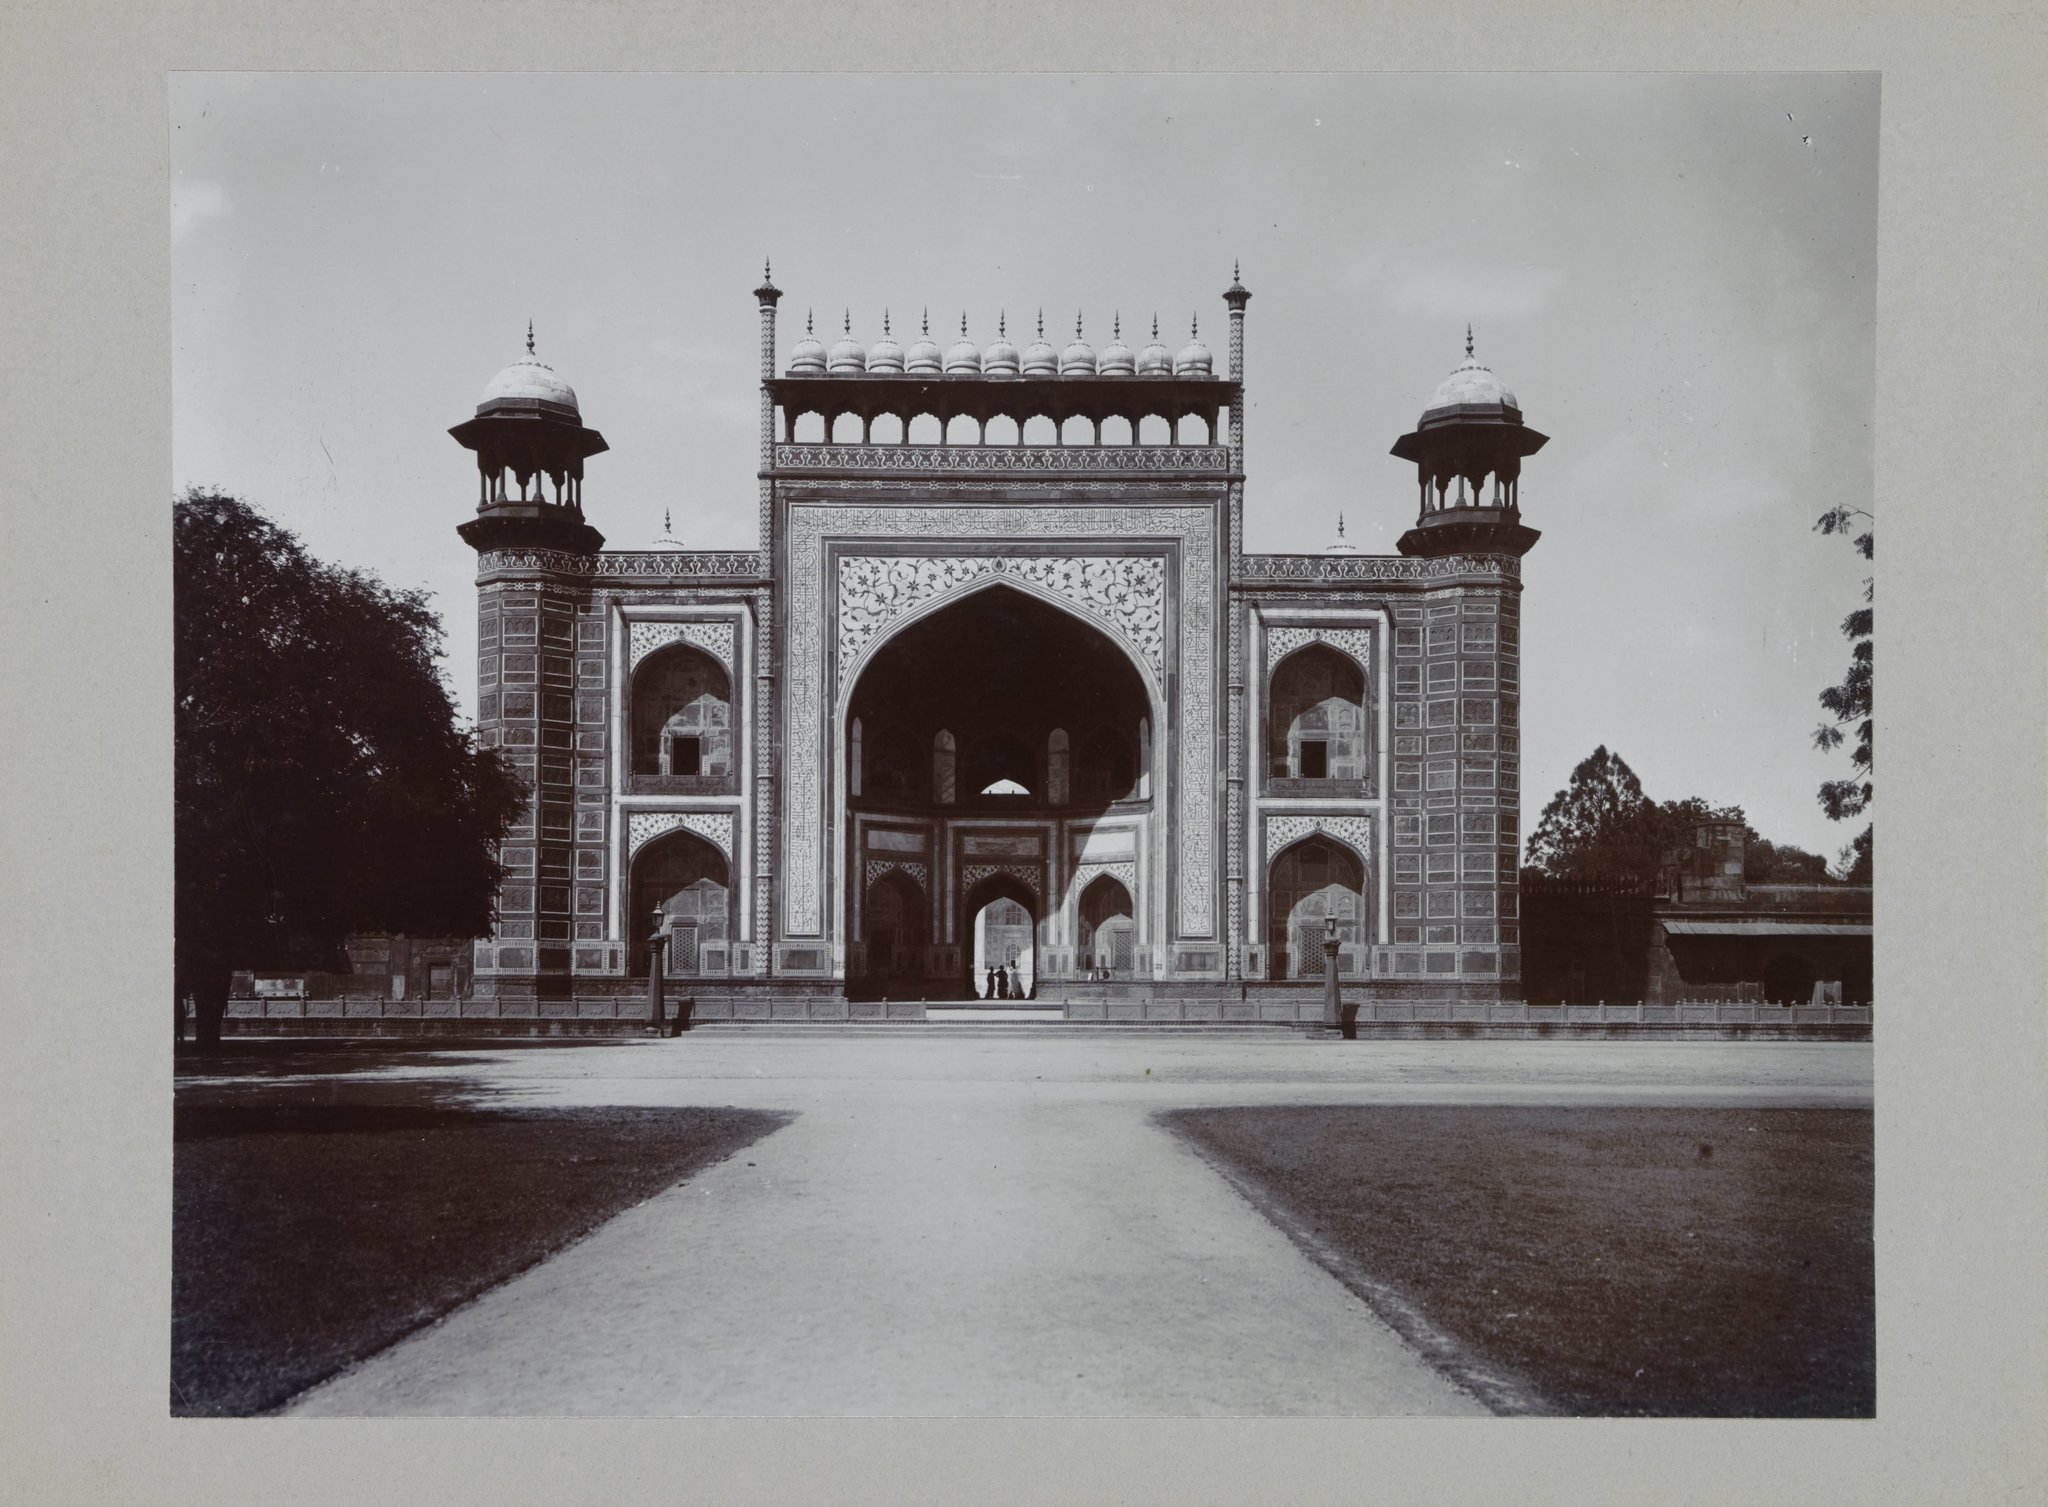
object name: photograph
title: Entrance to the Taj Mahal, Agra, Uttar Pradesh, India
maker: Anonymous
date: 1895-1915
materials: cardboard, paper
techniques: gelatin silver print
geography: agra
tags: agra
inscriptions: annotation: ‘53. Ingang v/d. Taj. Mahal.’